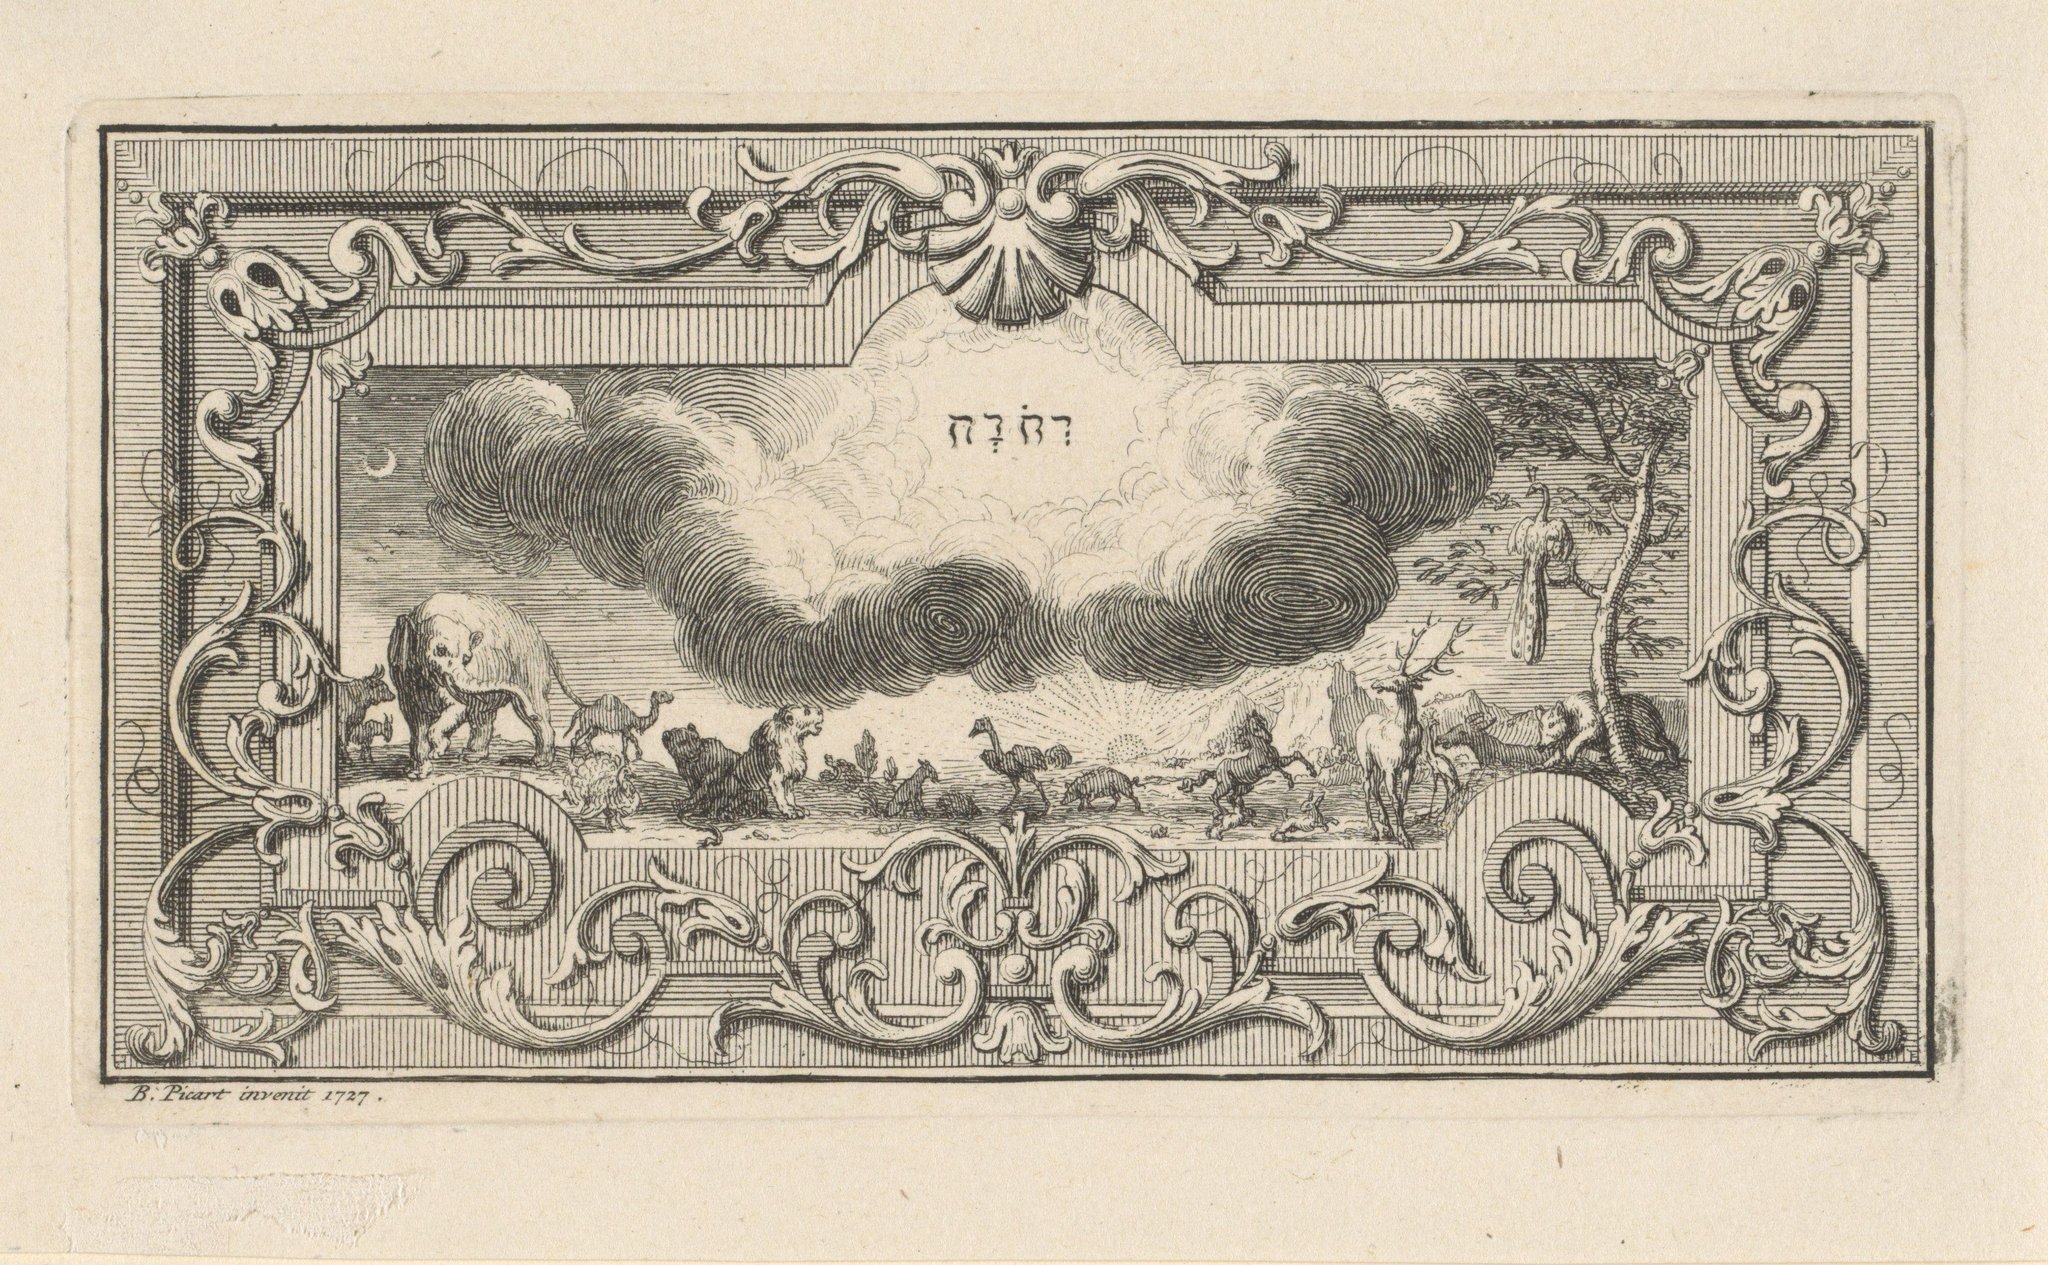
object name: ornament print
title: Tetragram boven een landschap met dieren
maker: bernard picart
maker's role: draughtsman, print maker, publisher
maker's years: 1673-1733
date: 1727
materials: paper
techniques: engraving, etching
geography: amsterdam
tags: ornaments ~ art, tetragram (in roman or hebrew script) ~ symbol of god the father, creation of the animals ~ genesis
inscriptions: collector's mark: Lugt 2228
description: Boven een landschap met opkomende zon en verschillende dieren staat het tetragram als symbool van God de Vader als schepper. De voorstelling is gevat in een ornamentele lijst.